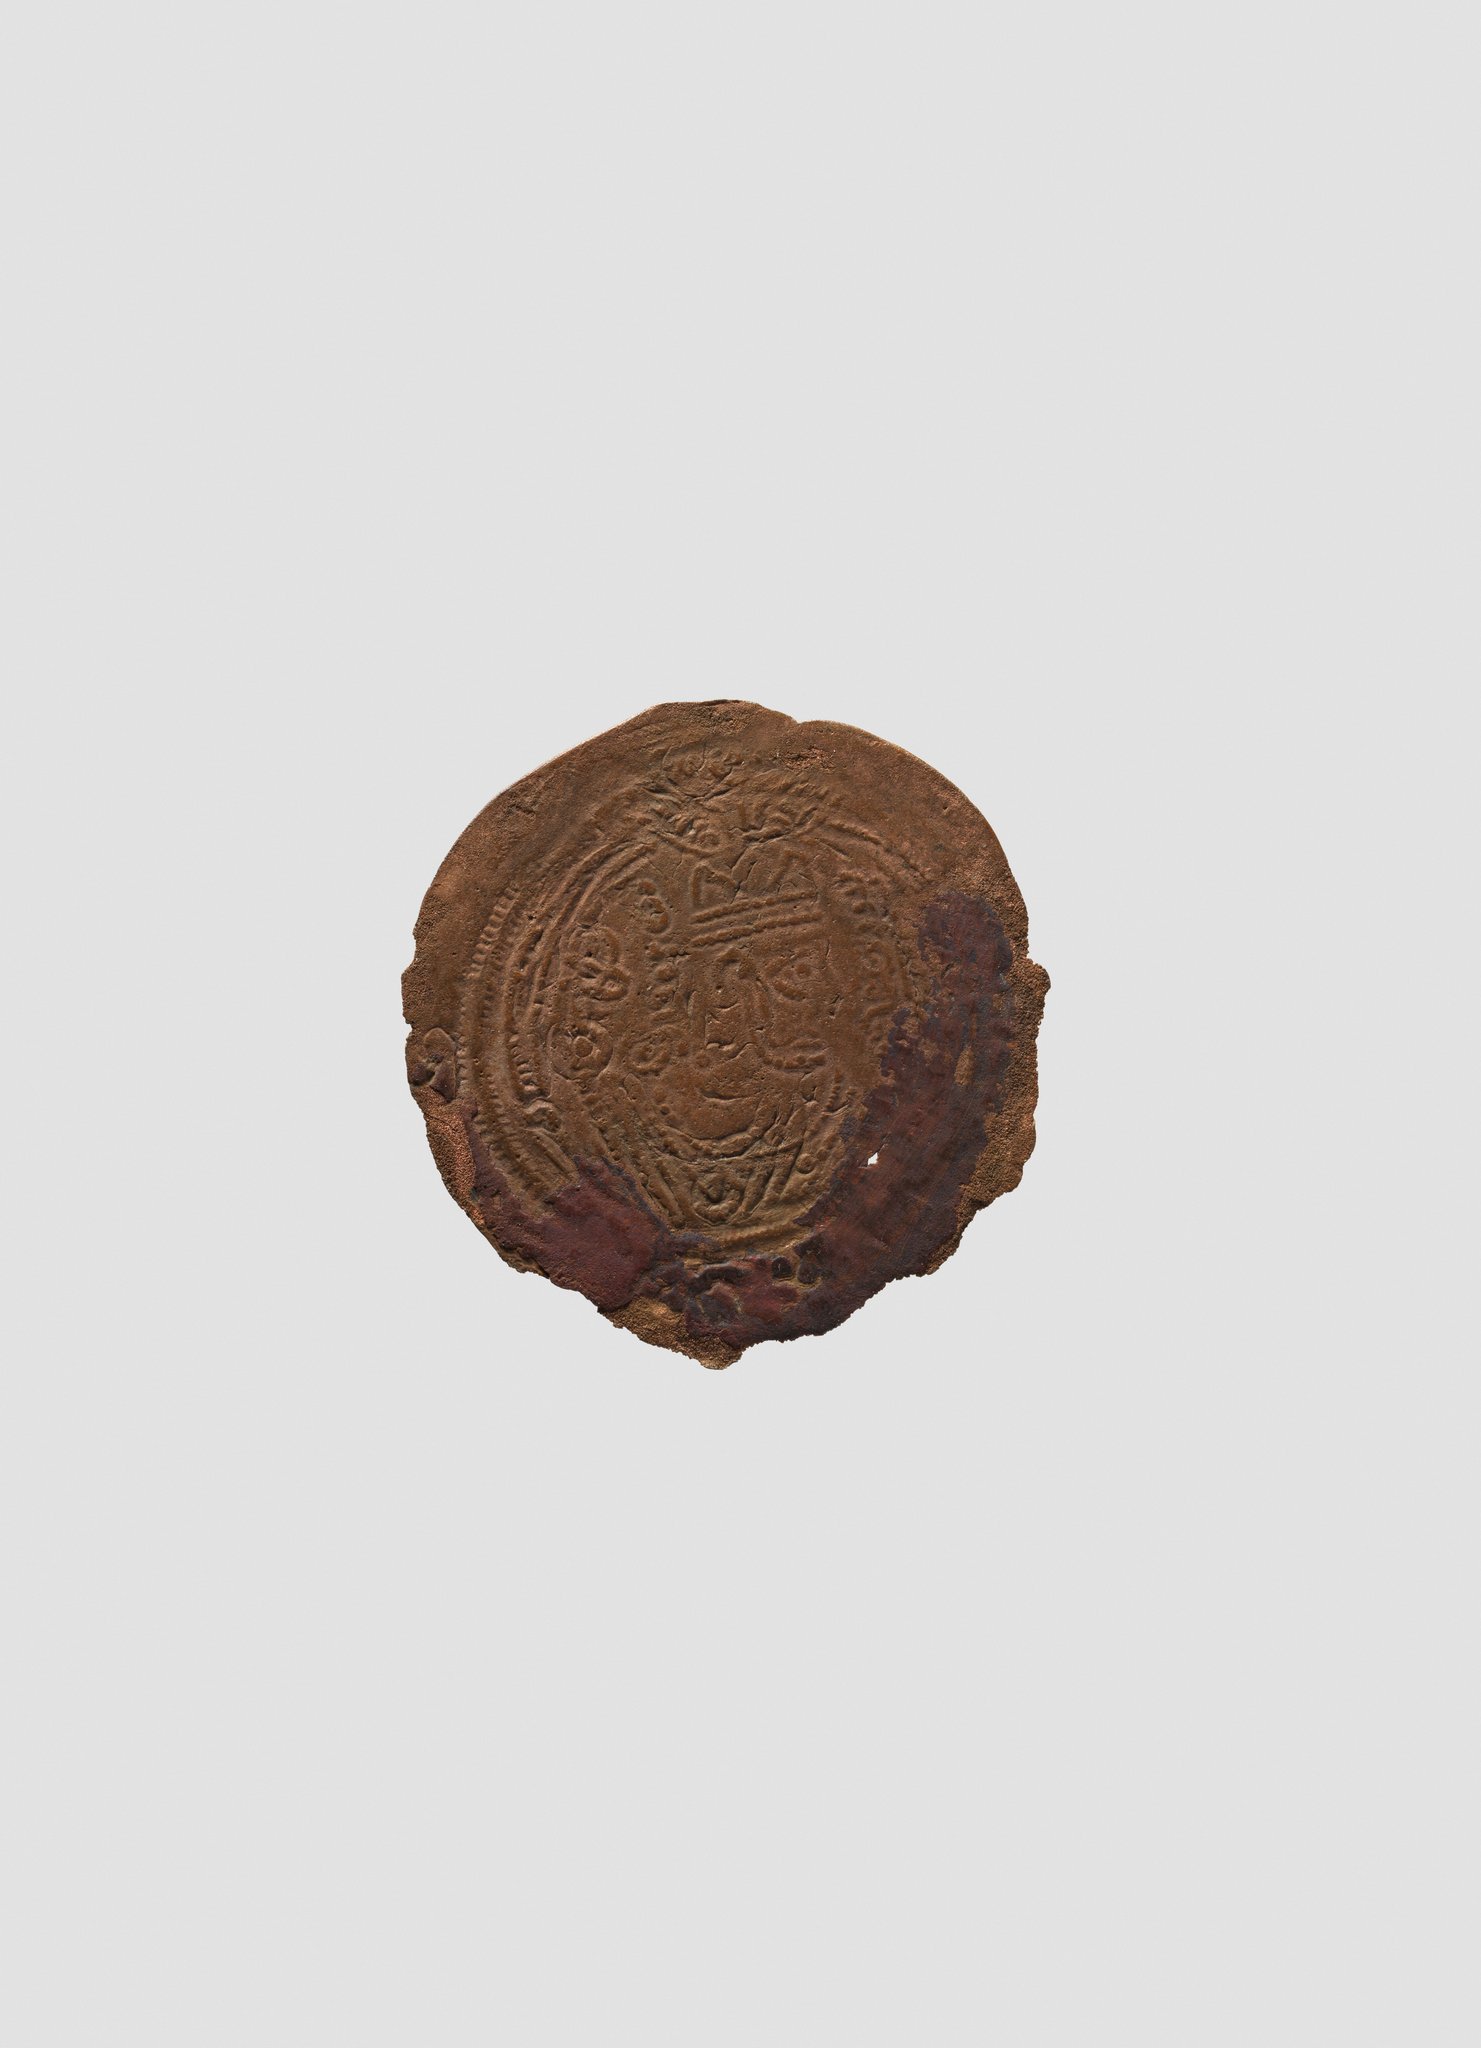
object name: coin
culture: islamic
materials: copper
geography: iran